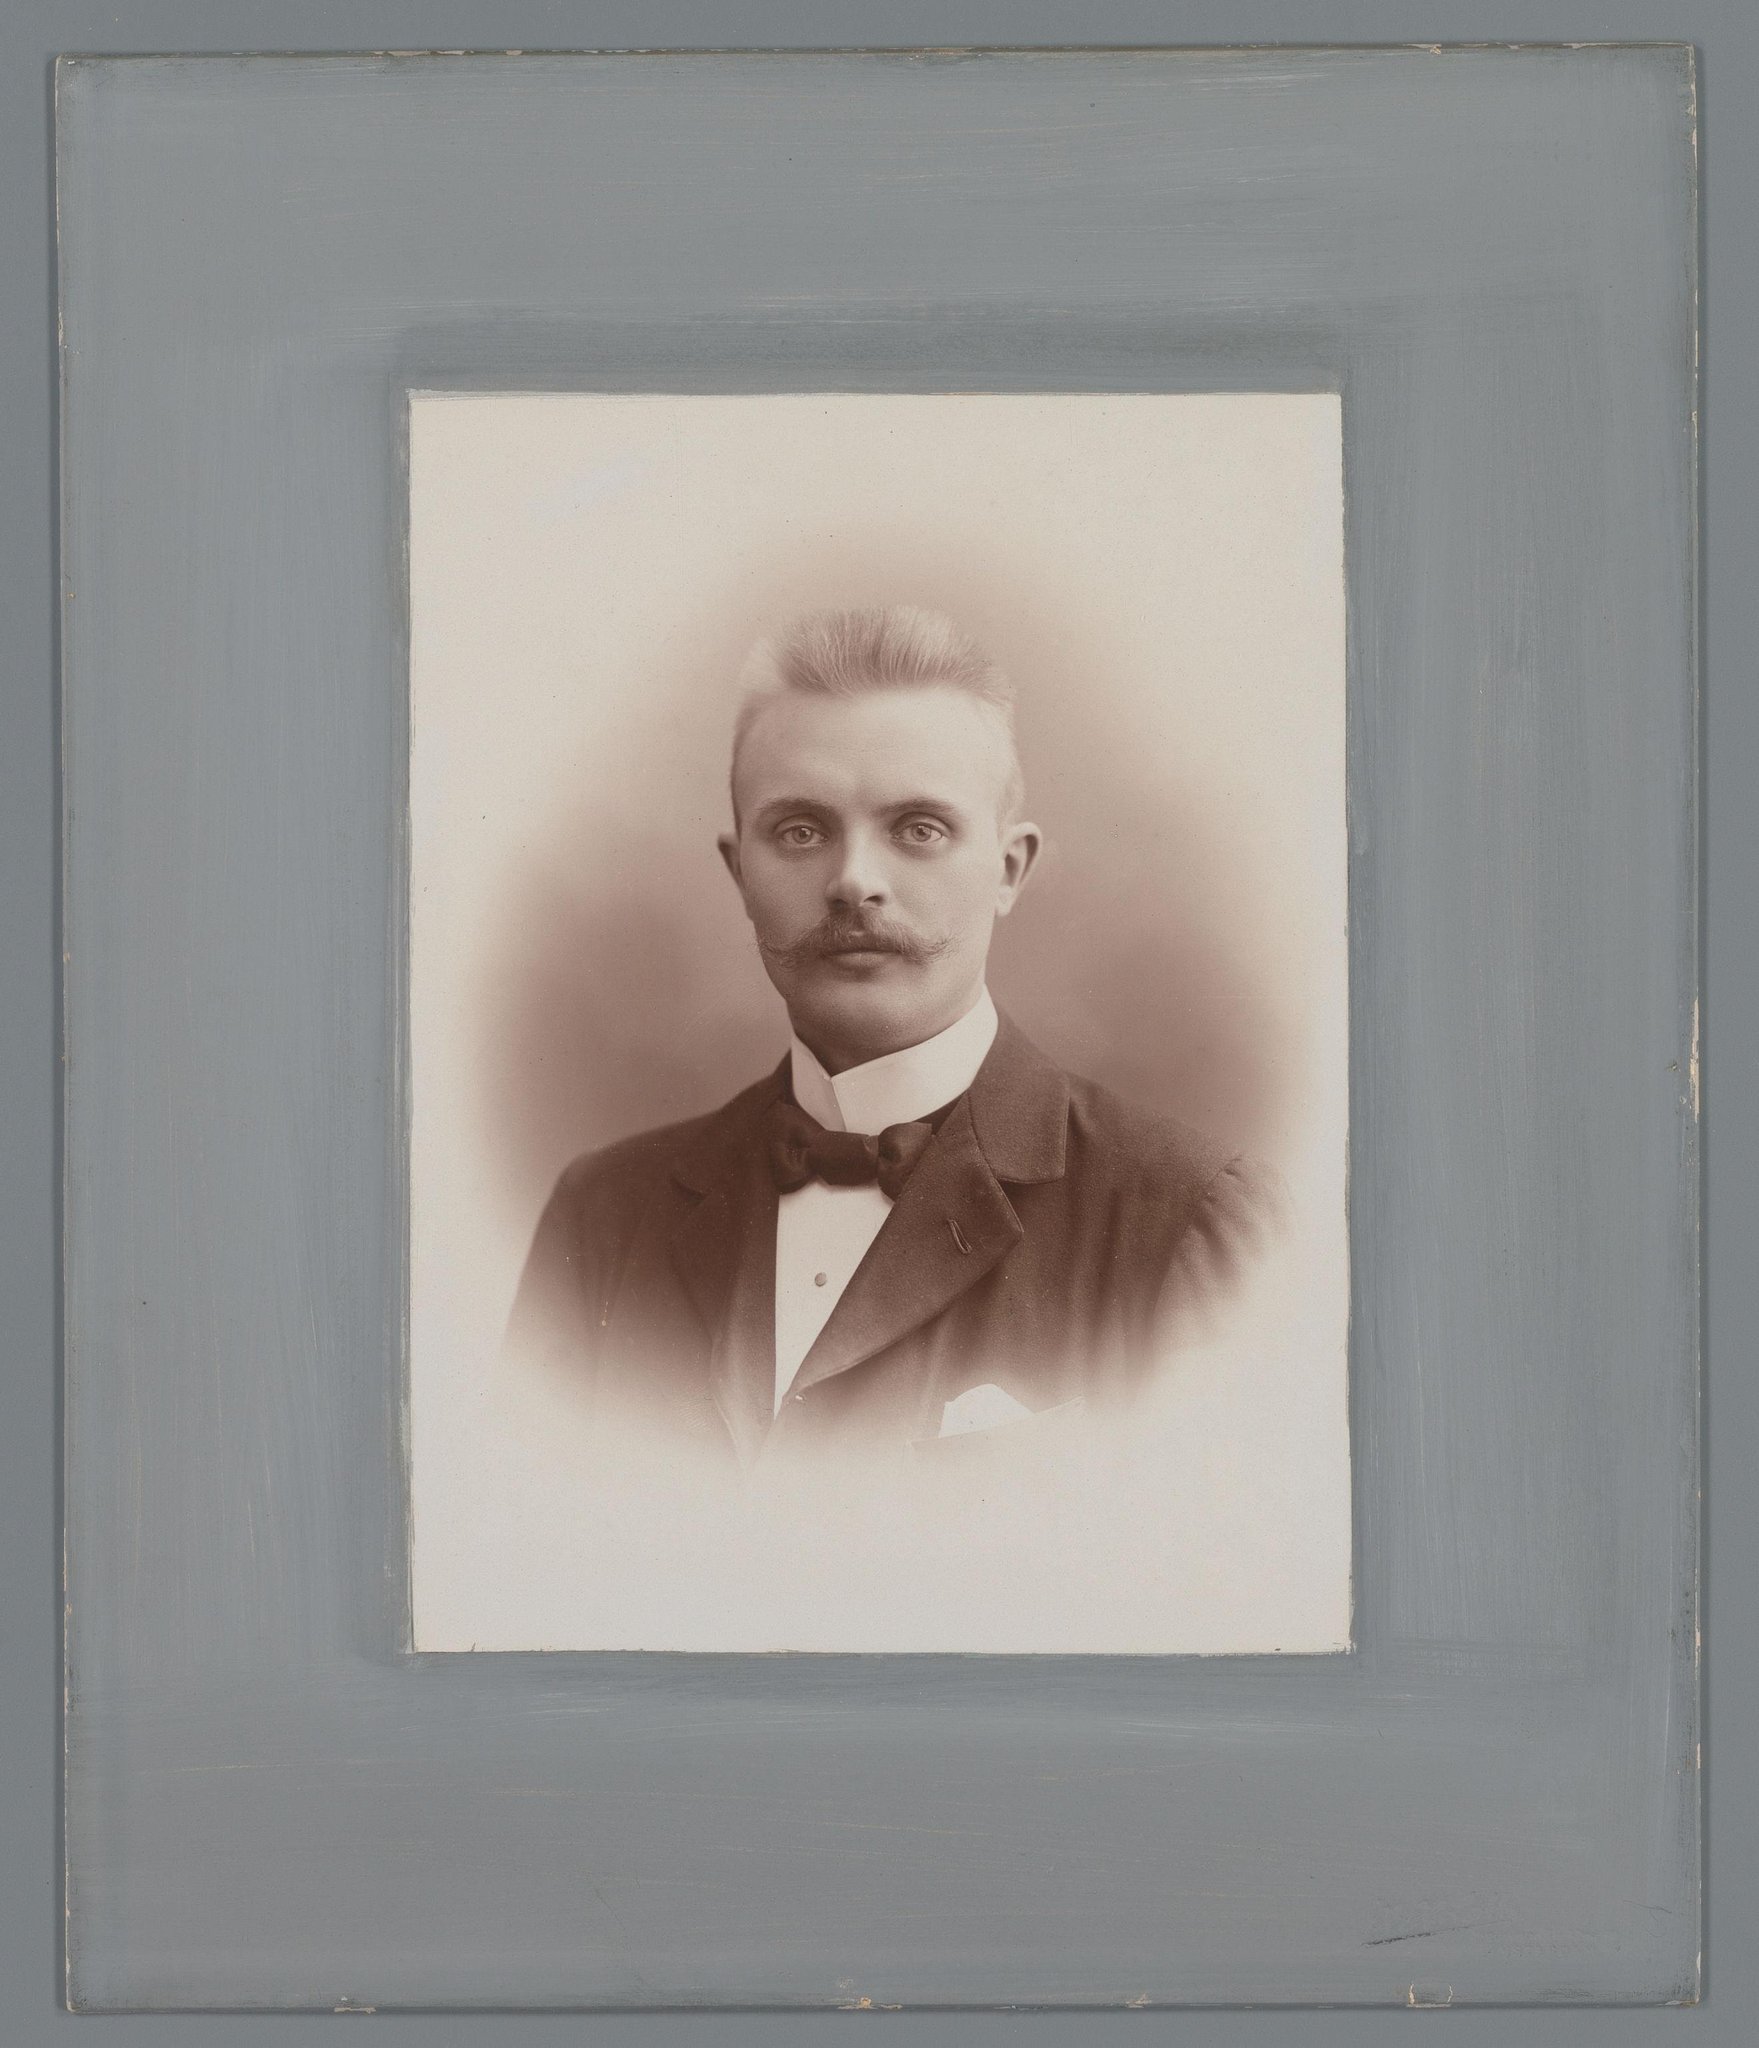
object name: photograph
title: Portret van een onbekende man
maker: machiel hendricus laddé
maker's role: fotograaf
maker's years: 1866-1932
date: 1890-1910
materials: paper, cardboard, paint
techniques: collodion silver print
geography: amsterdam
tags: anonymous historical person portrayed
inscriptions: address: ‘Nieuwendijk 57 en 59/ AMSTERDAM’